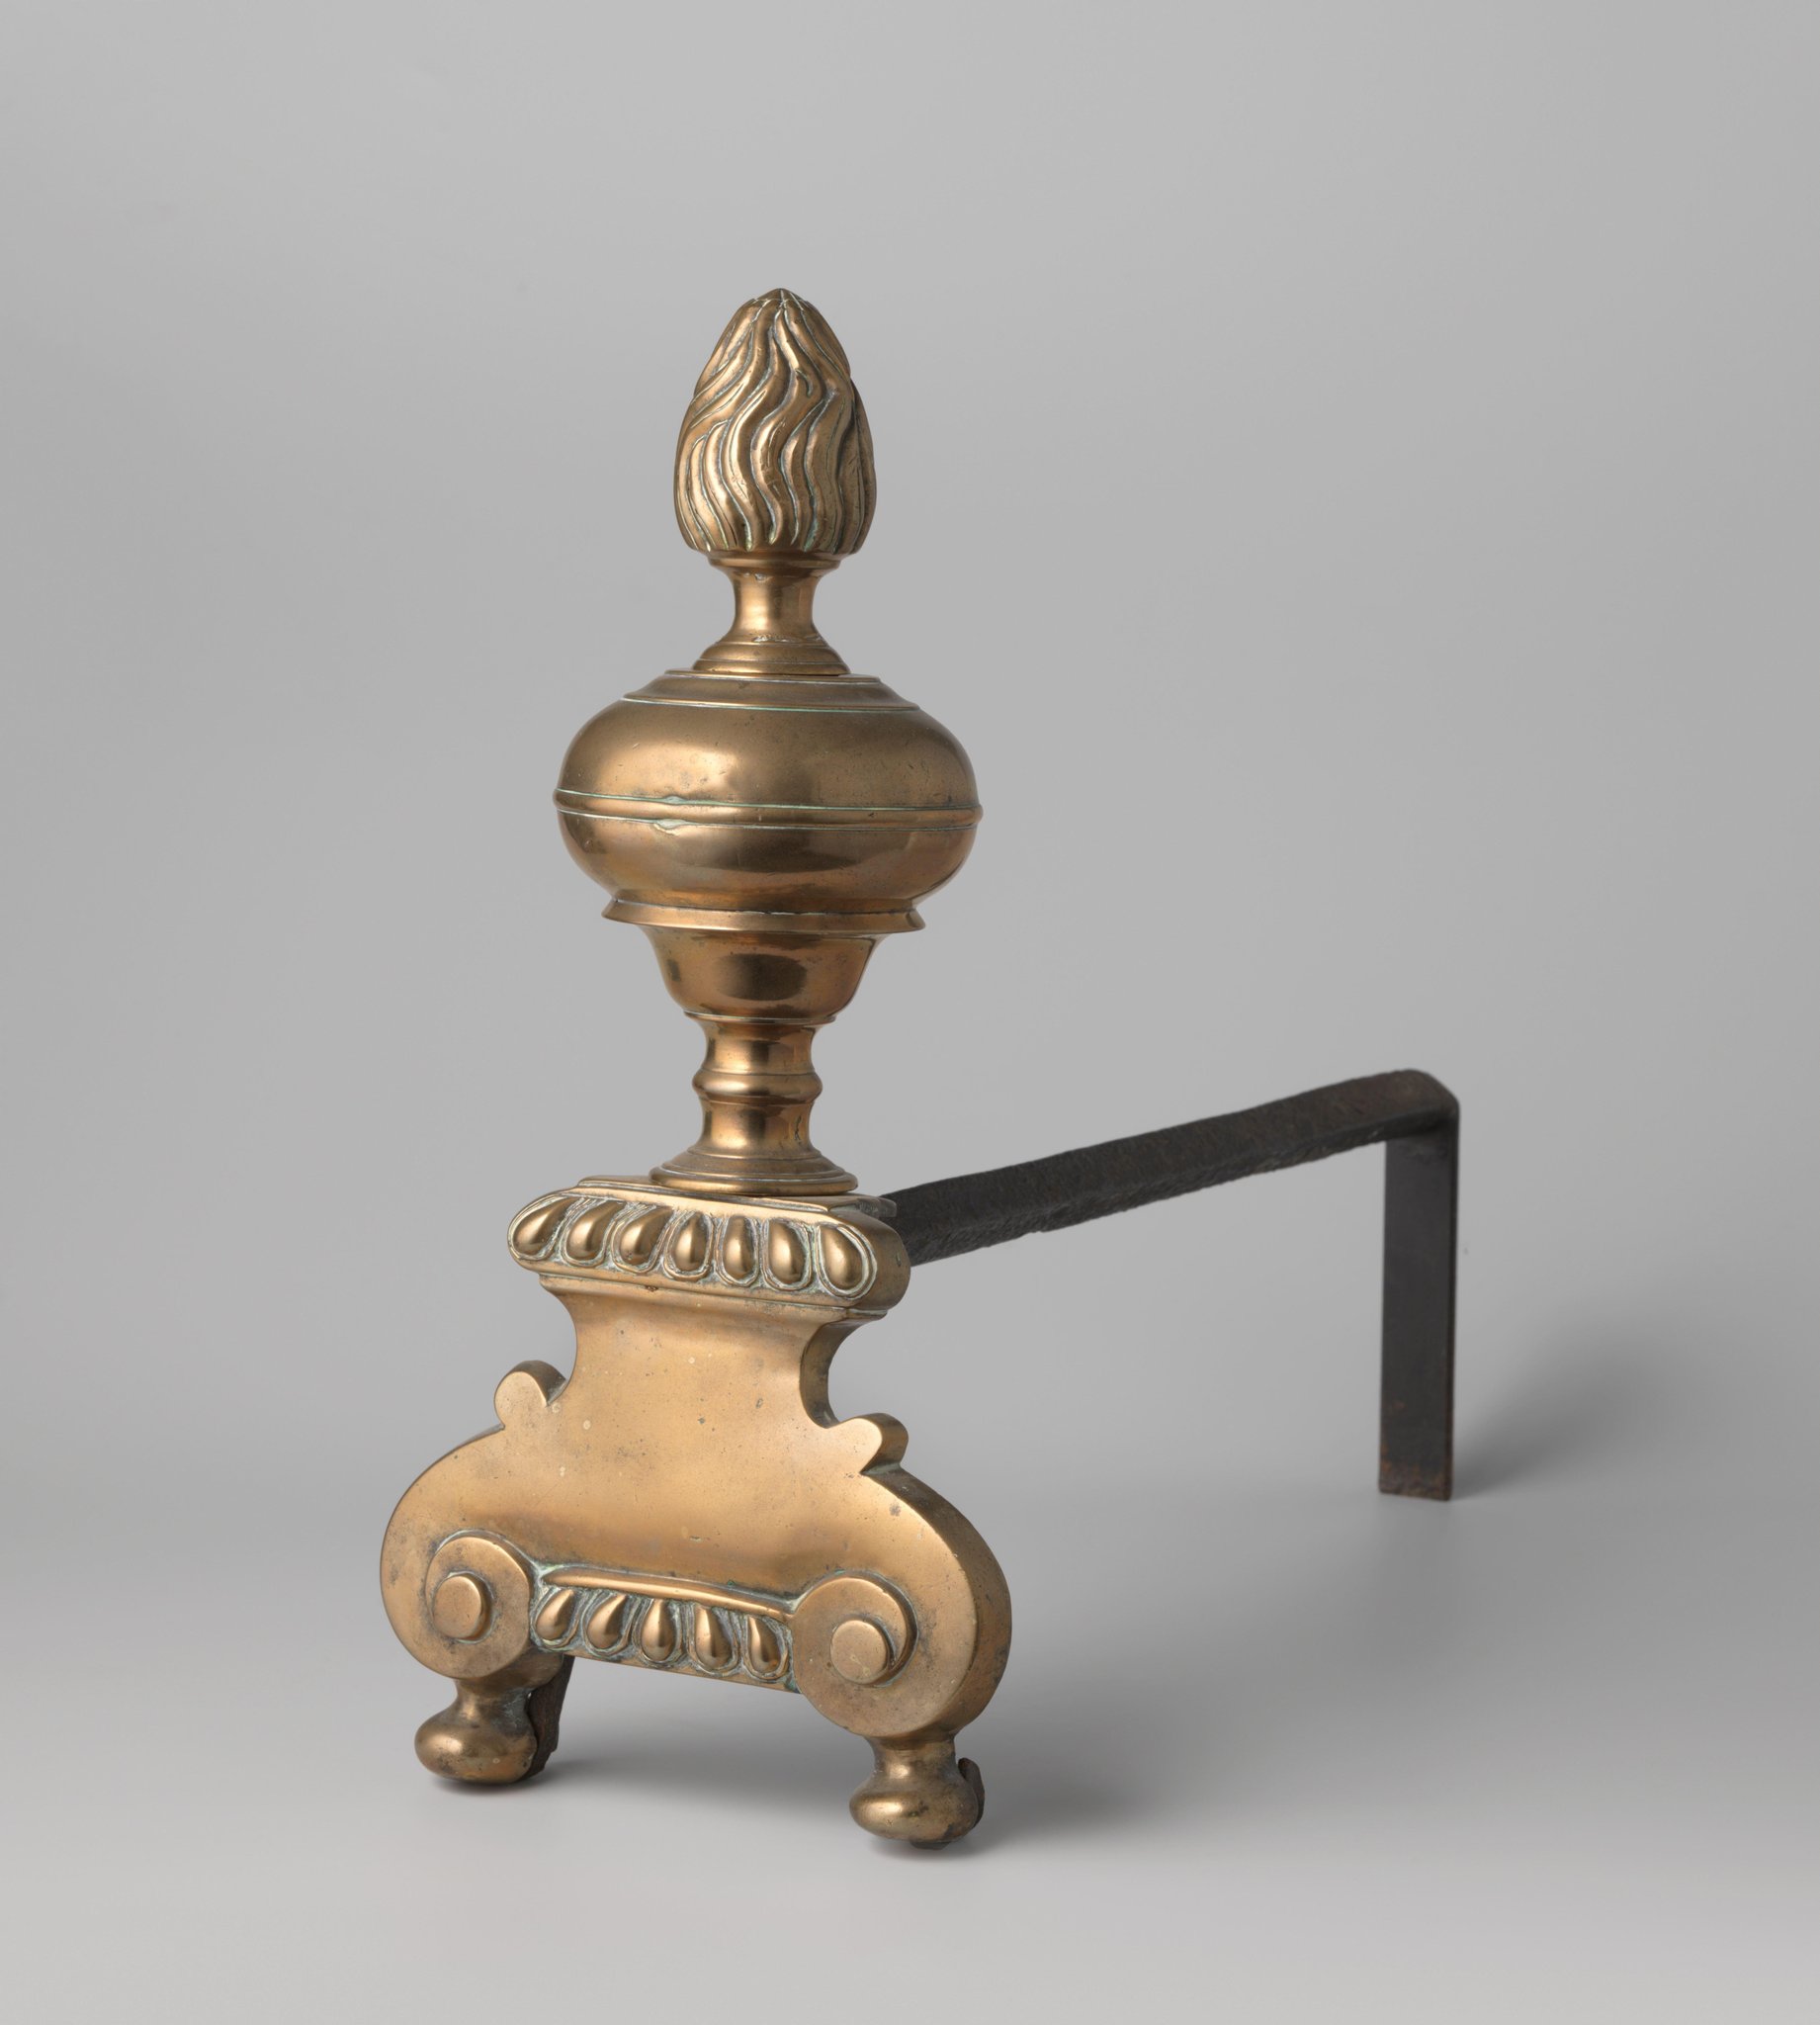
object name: andiron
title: Haardijzer met een versiering bestaande uit een basis, een vaas en een knop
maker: Anonymous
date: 1675-1700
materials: brass, iron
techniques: casting, forging, riveted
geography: france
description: Het voorwerp bestaat uit ene uit vier smeedijzeren stangen aaneengeklonken deel, waarop het hout gelegd kan worden en waaraan de in drie delen gegoten en geciseleerde versiering van geel koper bevestigd is. Deze bestaat uit een basis, een vaas en een knop. De basis loopt onderaan uit in twee krullen en staat op twee poten. Hij heeft bovenaan een gat en achter de poten twee uitsteeksels, waardoor hij op het ijzeren deel kan worden geplaatst. De geprofileerde vaas verbreedt zich naar boven toe tot een platte bol. De geprofileerde knop heeft de vorm van een vlam. De knop is onderaan nagenoeg massief en wijkt in details en door een meer gele kleur iets af. Hij is misschien bijgemaakt toen een van een schroefdraad voorziene stang op het ijzeren deel is aangebracht.